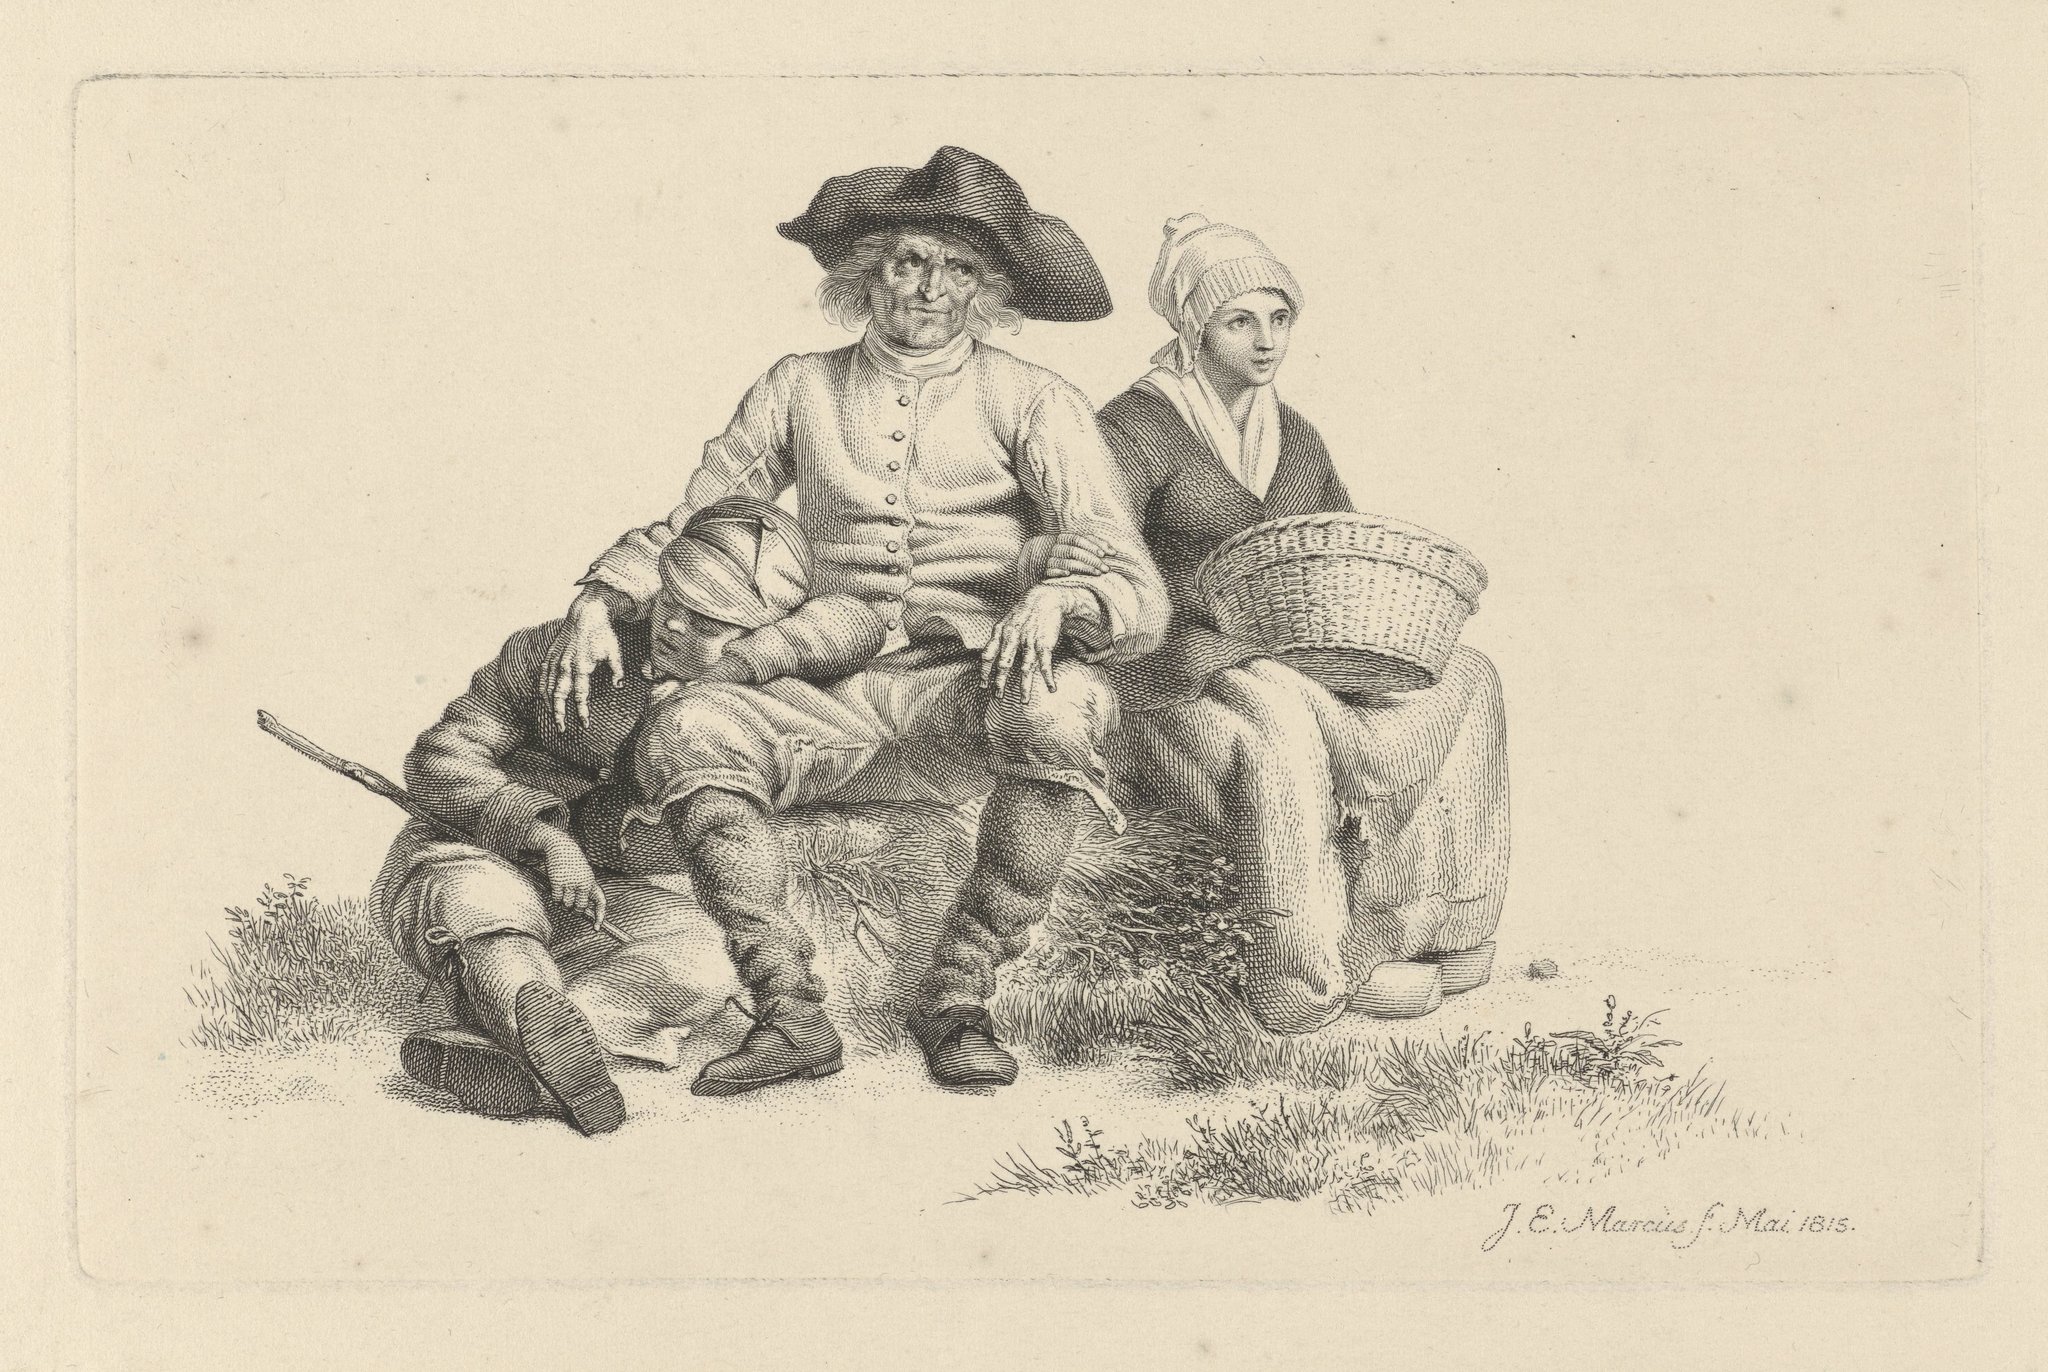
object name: print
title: Studie-prentwerk / Etudes gravées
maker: jacob ernst marcus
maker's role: draughtsman, print maker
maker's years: 1774-1826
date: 1805-1815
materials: paper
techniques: etching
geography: amsterdam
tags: boy (child between toddler and youth) (+ sitting on the ground), family group, especially parents with their child(ren), container made of plant material other than wood: basket, sleeping; unconsciousness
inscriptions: collector's mark: Lugt 2228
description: Serie voor het eerst uitgegeven door Jacob Ernst Marcus onder de titel Studiebeelden en Fragmenten. Amsterdam: ca.1816. Later heruitgegeven als: Studie-prentwerk/ Etudes gravées.